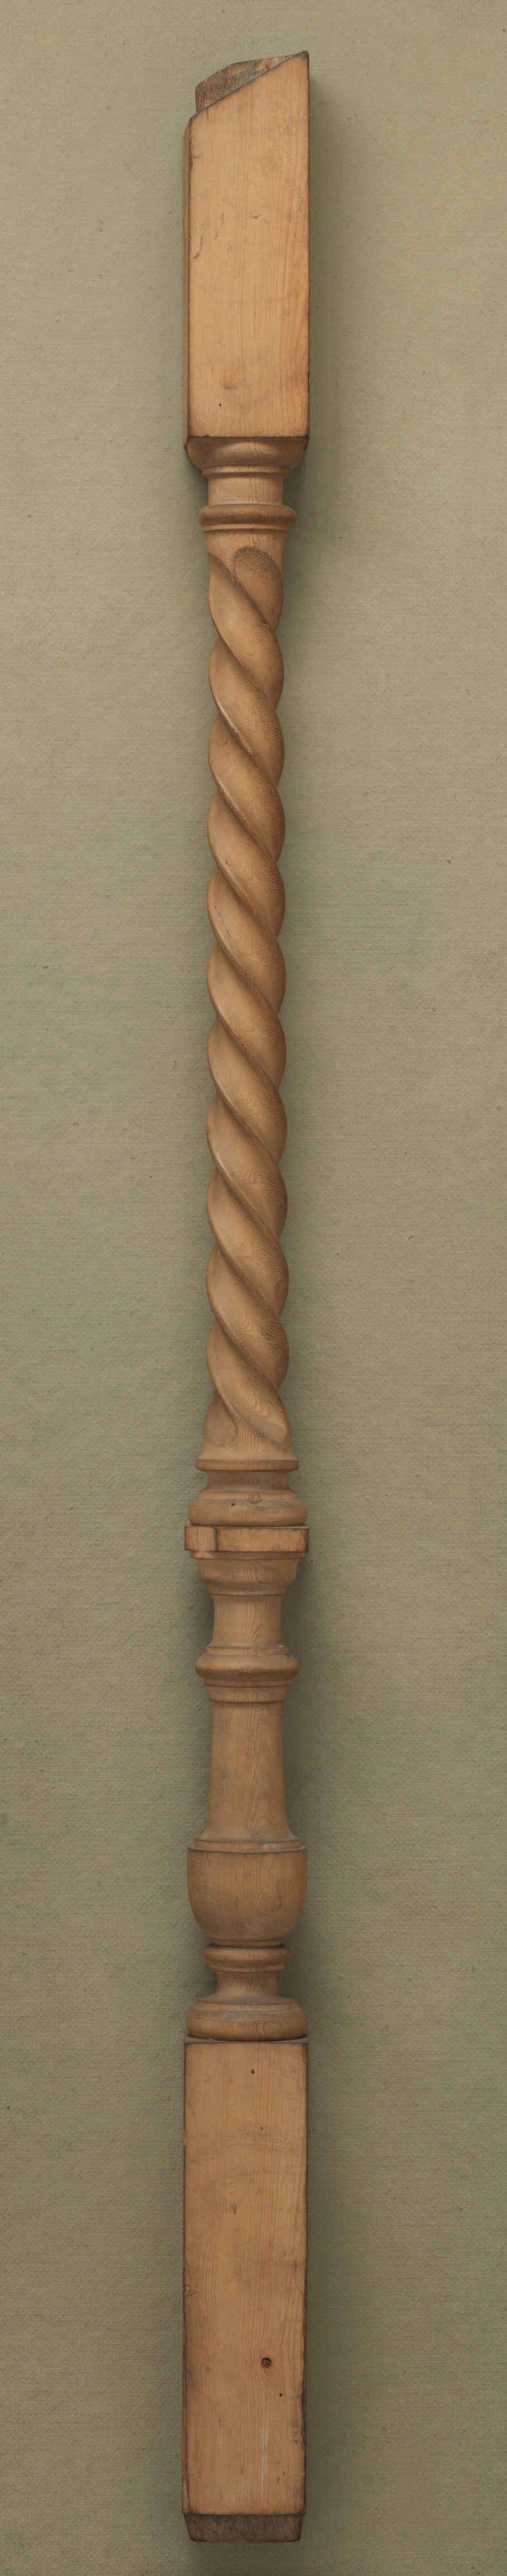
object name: baluster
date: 1734-1766